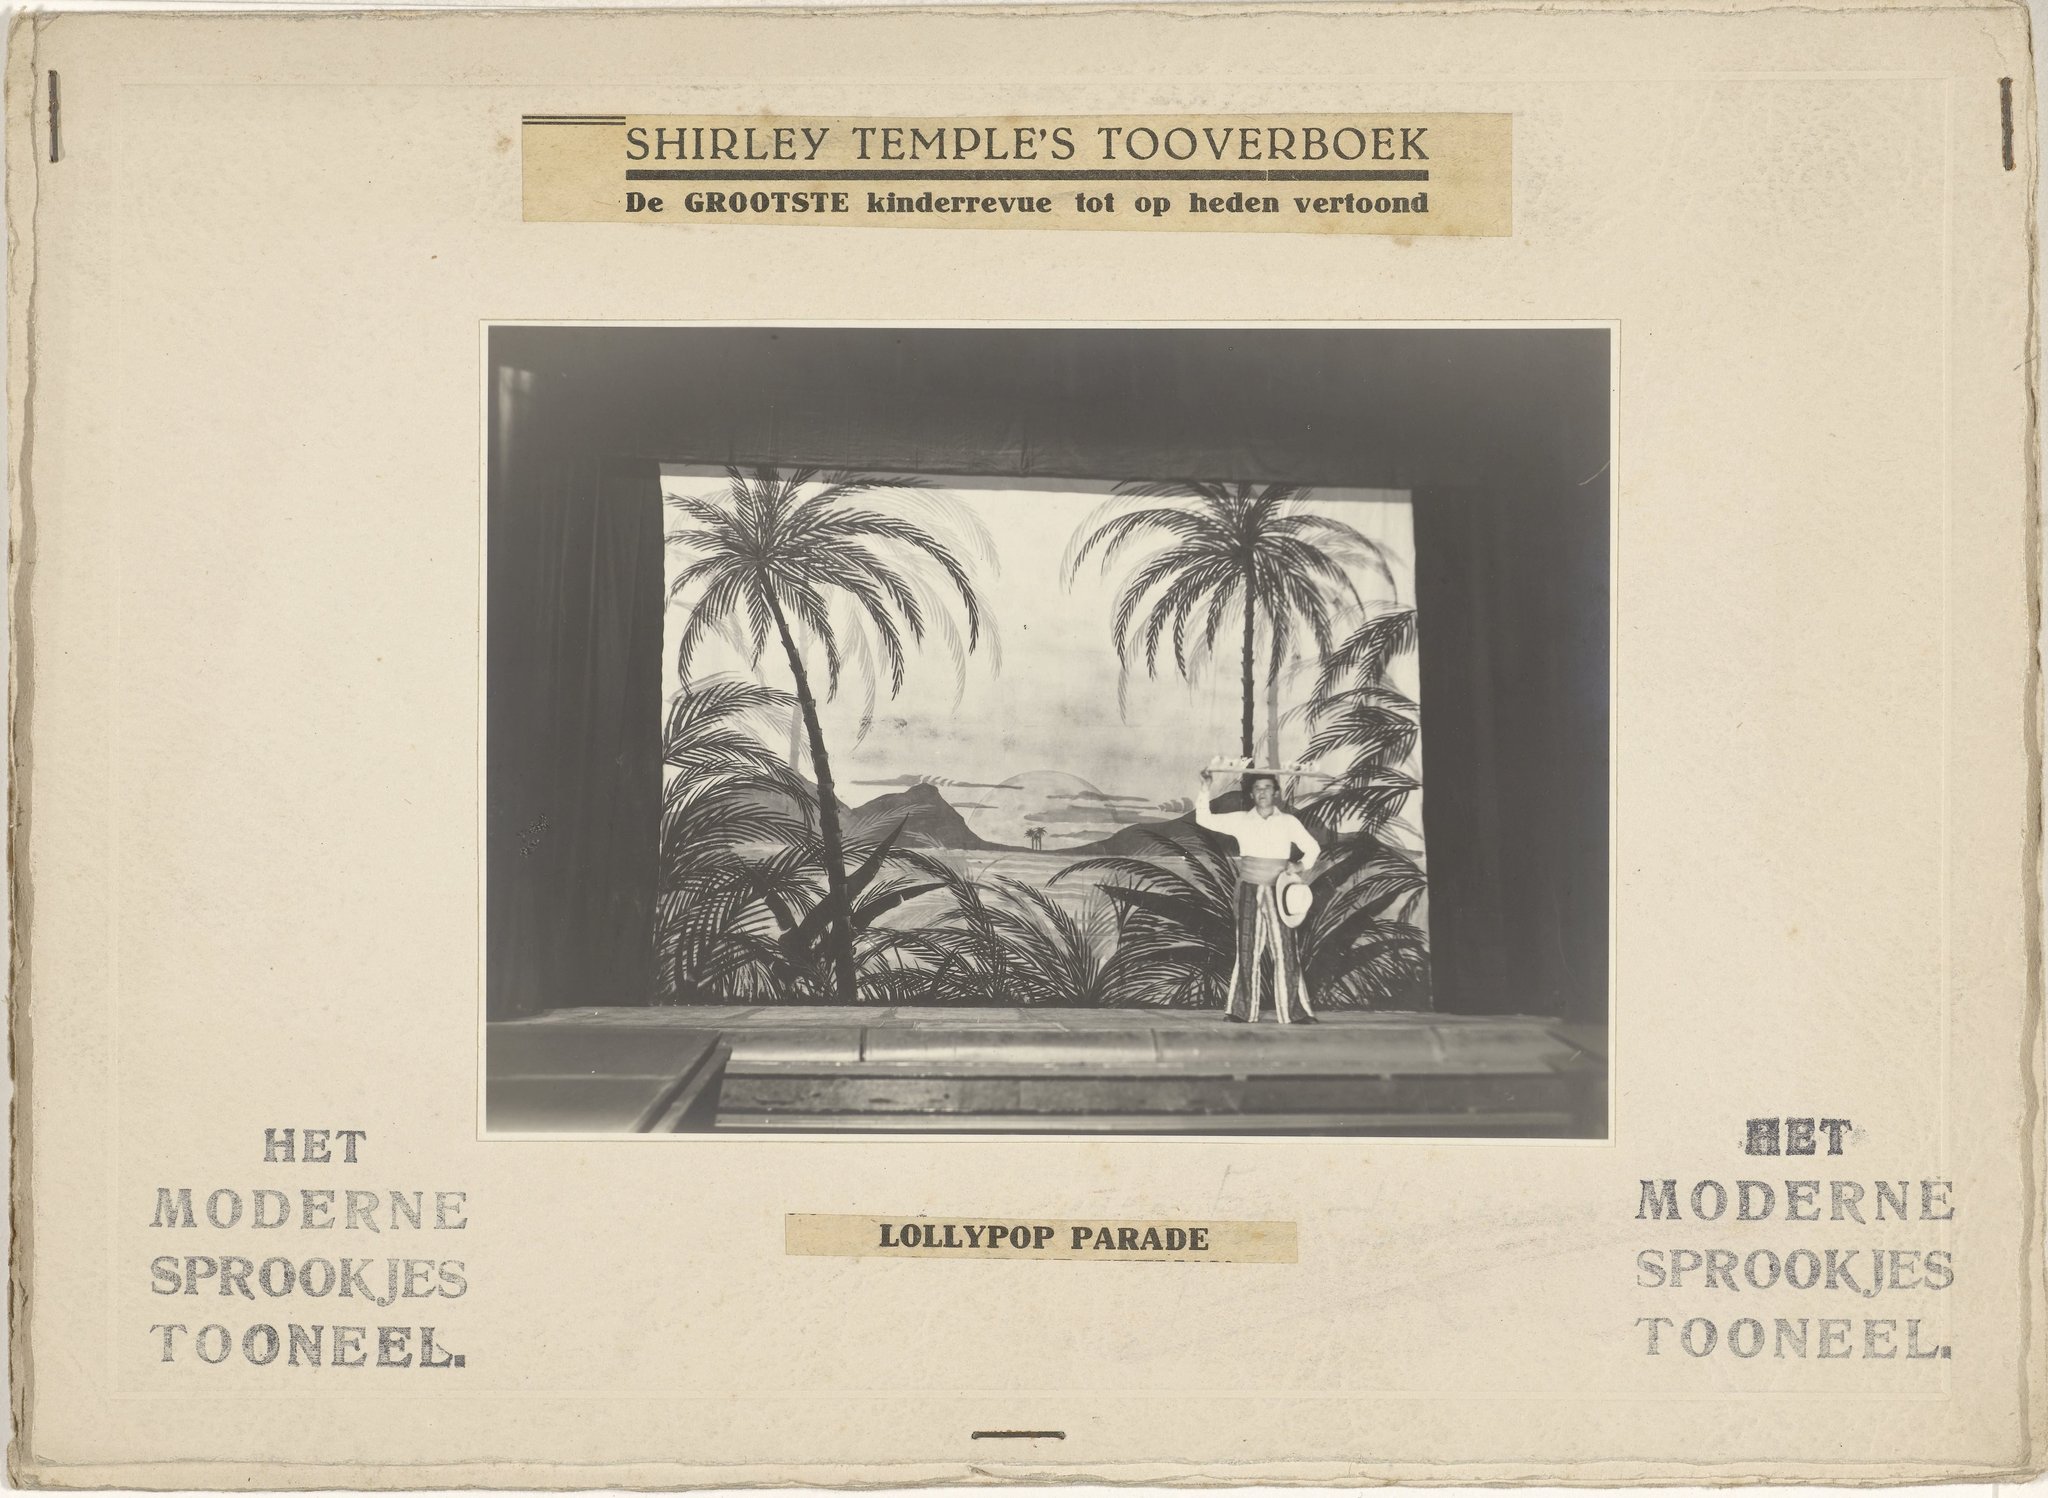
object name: photograph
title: Theaterfoto van acteur voor palmendecor uit de Lollypop parade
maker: Anonymous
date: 1927-1935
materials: cardboard, photographic support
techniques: gelatin silver print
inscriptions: stamp: ‘Het moderne sprookjestoneel’